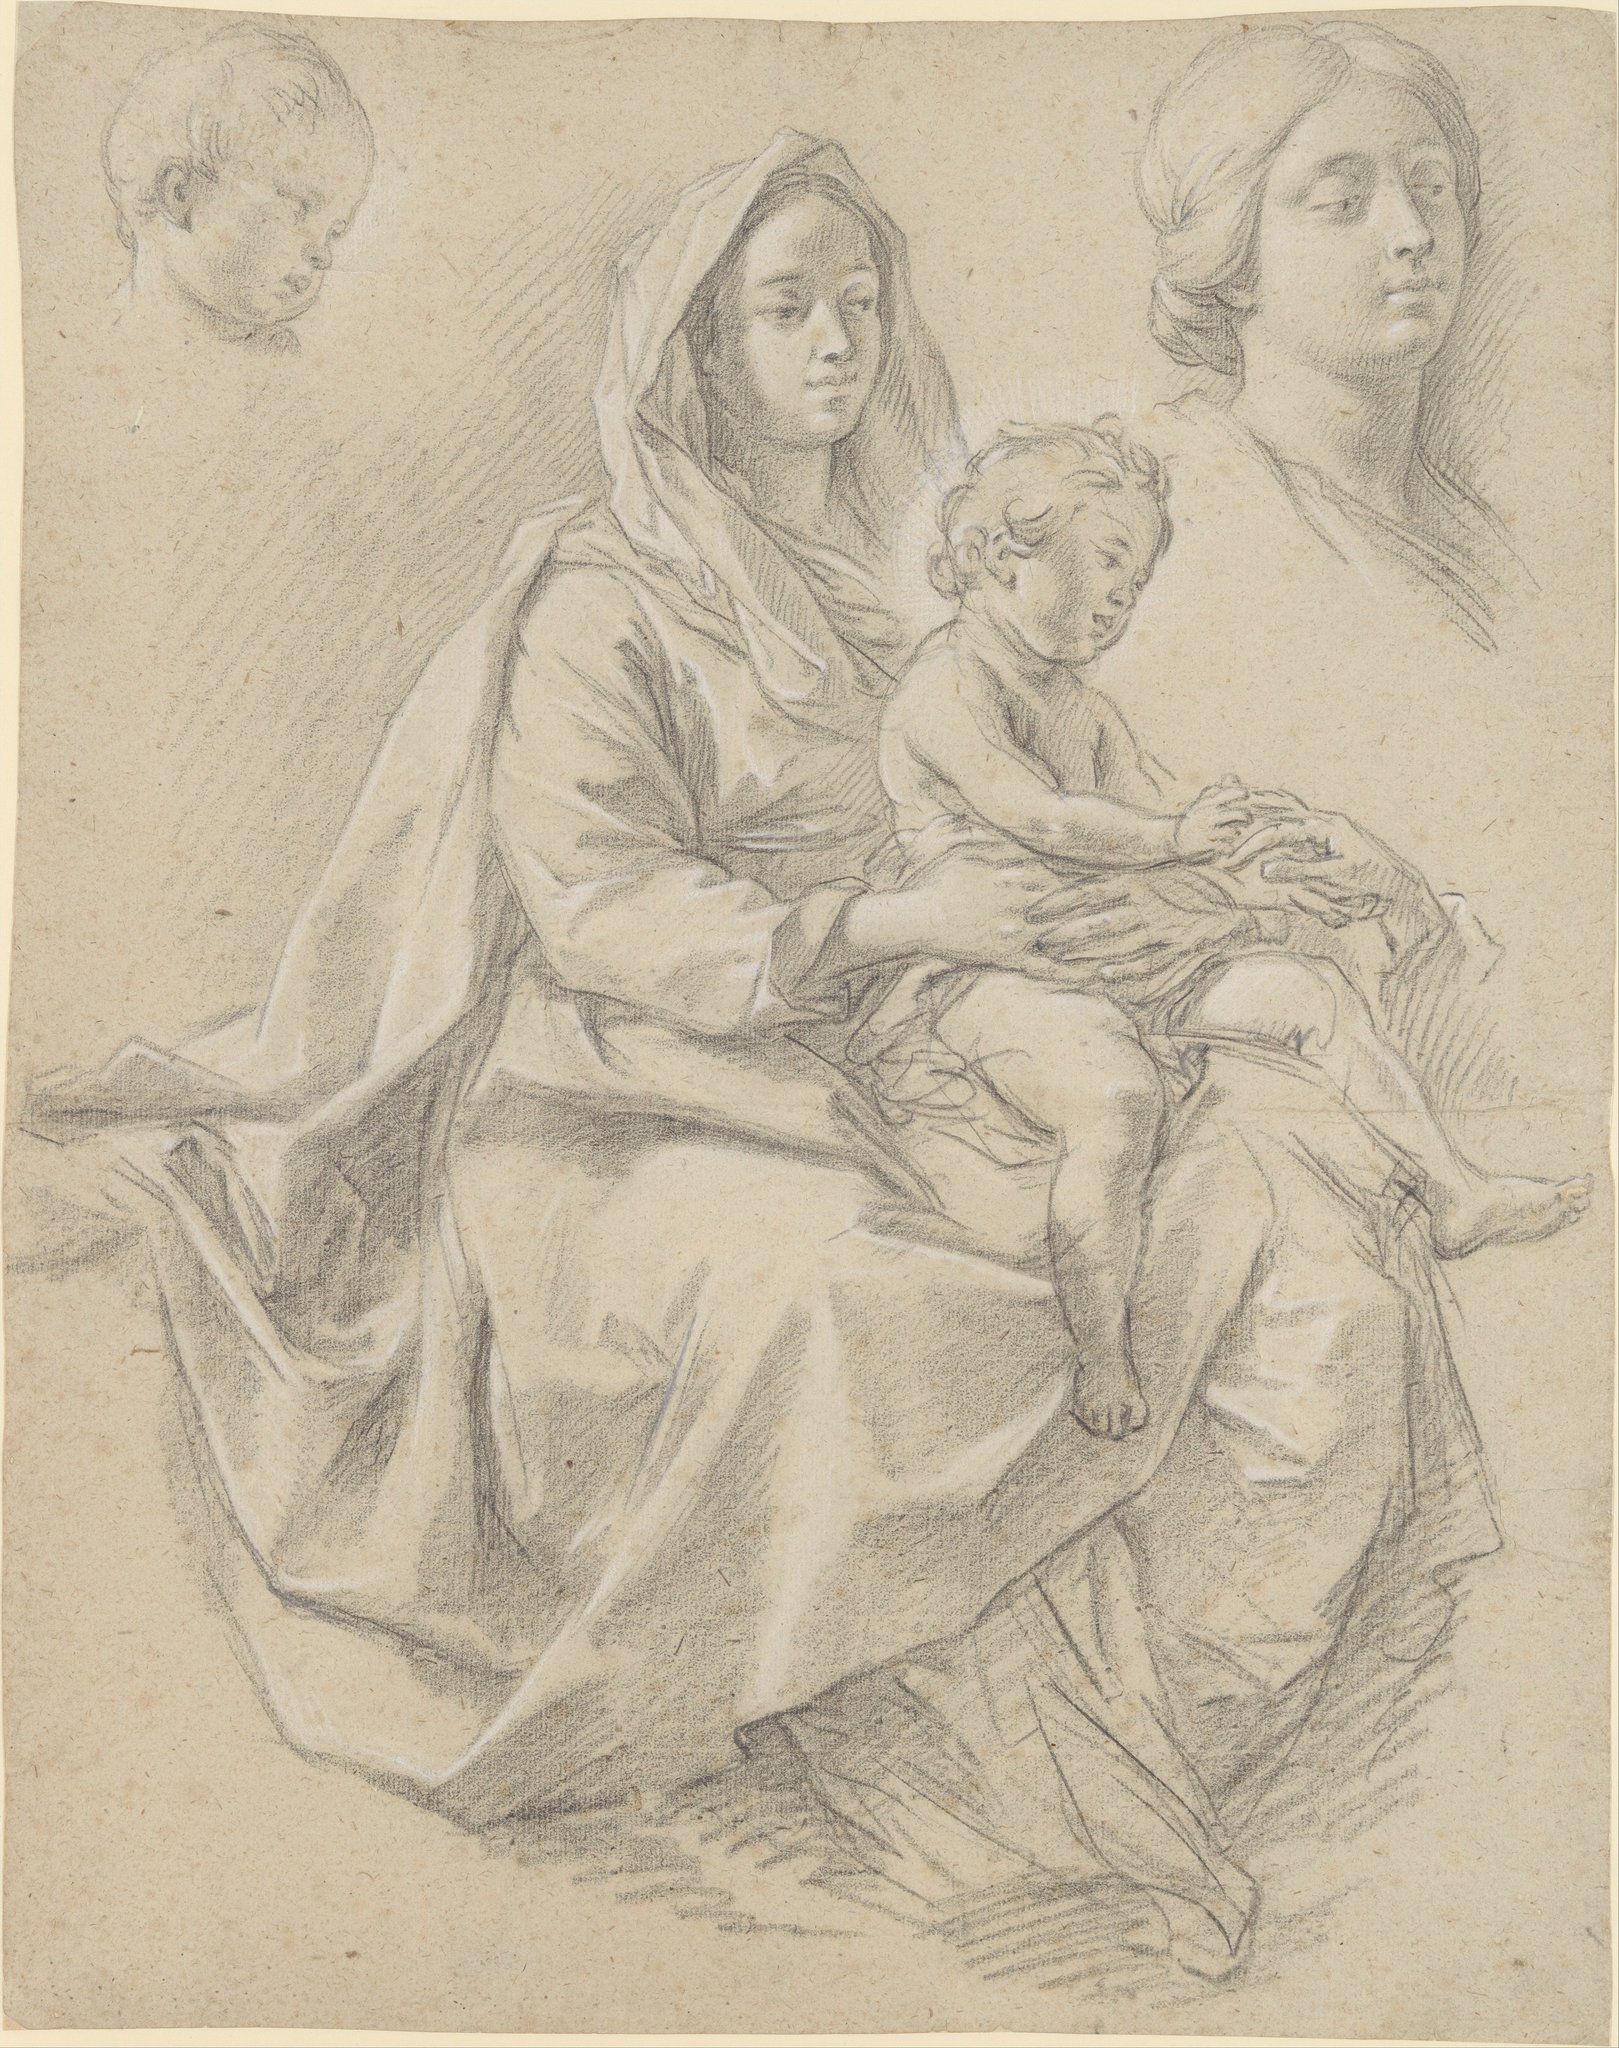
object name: drawing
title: Seated Woman with a Child on her Lap (Study for a Mystic Marriage of St. Catherine of Alexandria)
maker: etienne parrocel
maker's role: artist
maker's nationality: french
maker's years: 1696-1776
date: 1701-1800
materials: chalk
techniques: heightening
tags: heads,infants,women